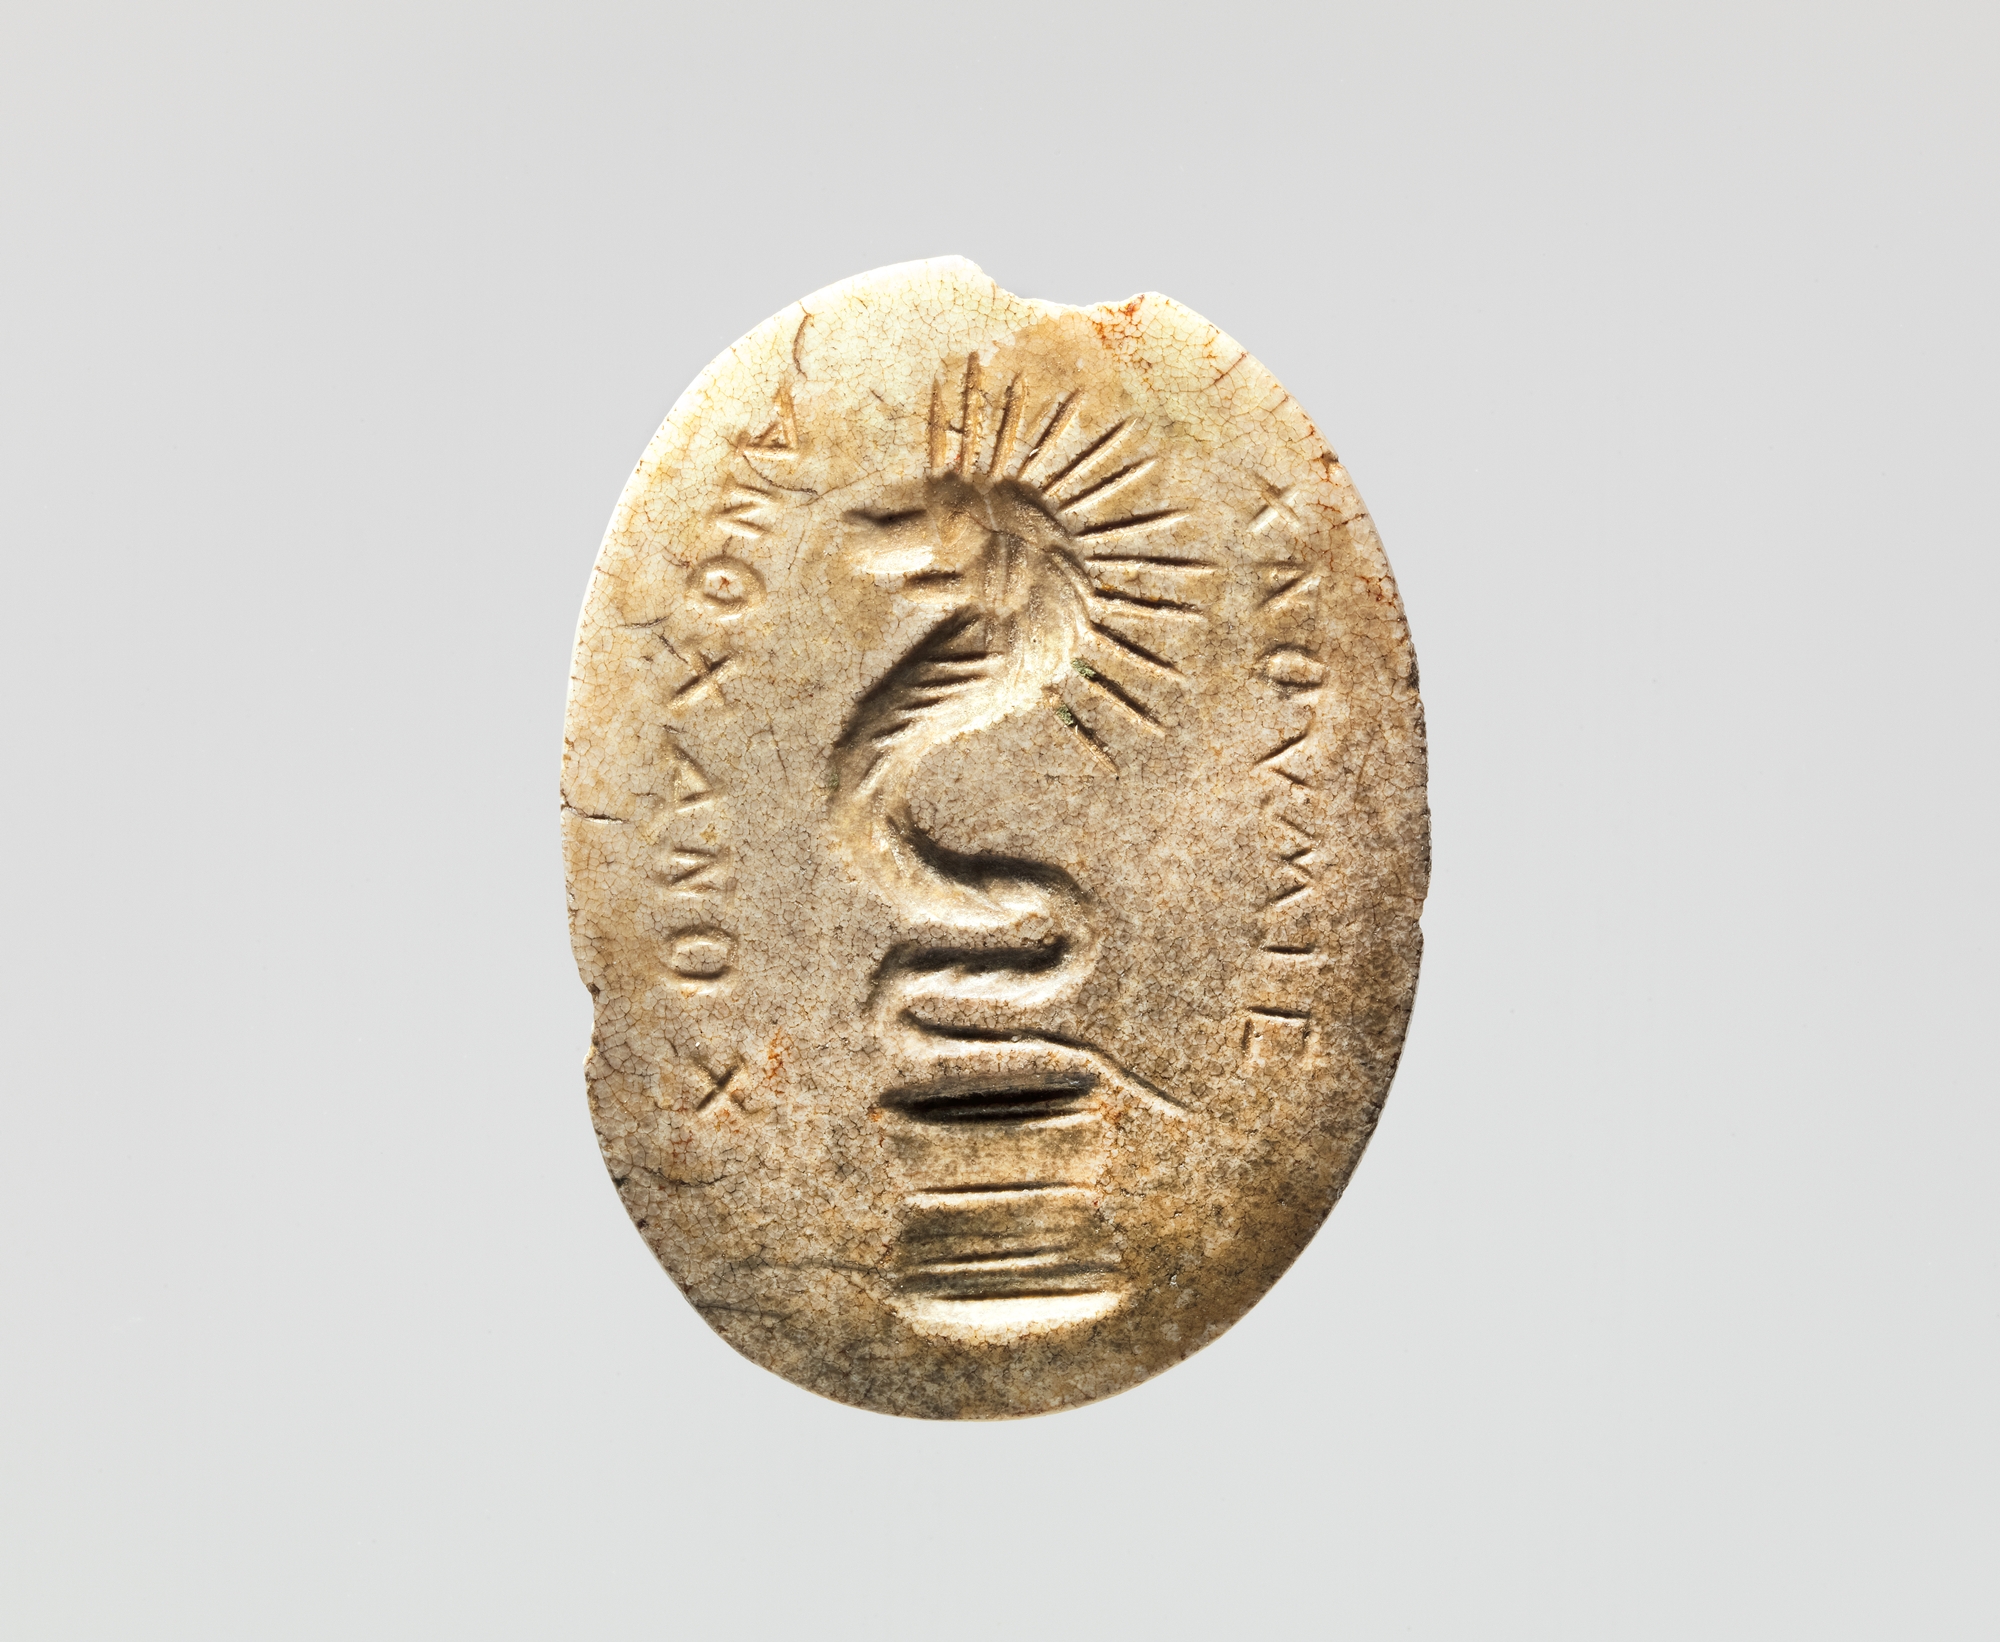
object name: intaglio, magical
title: Carnelian intaglio: Lion-headed serpent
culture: roman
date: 101-300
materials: gemstone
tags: serpents